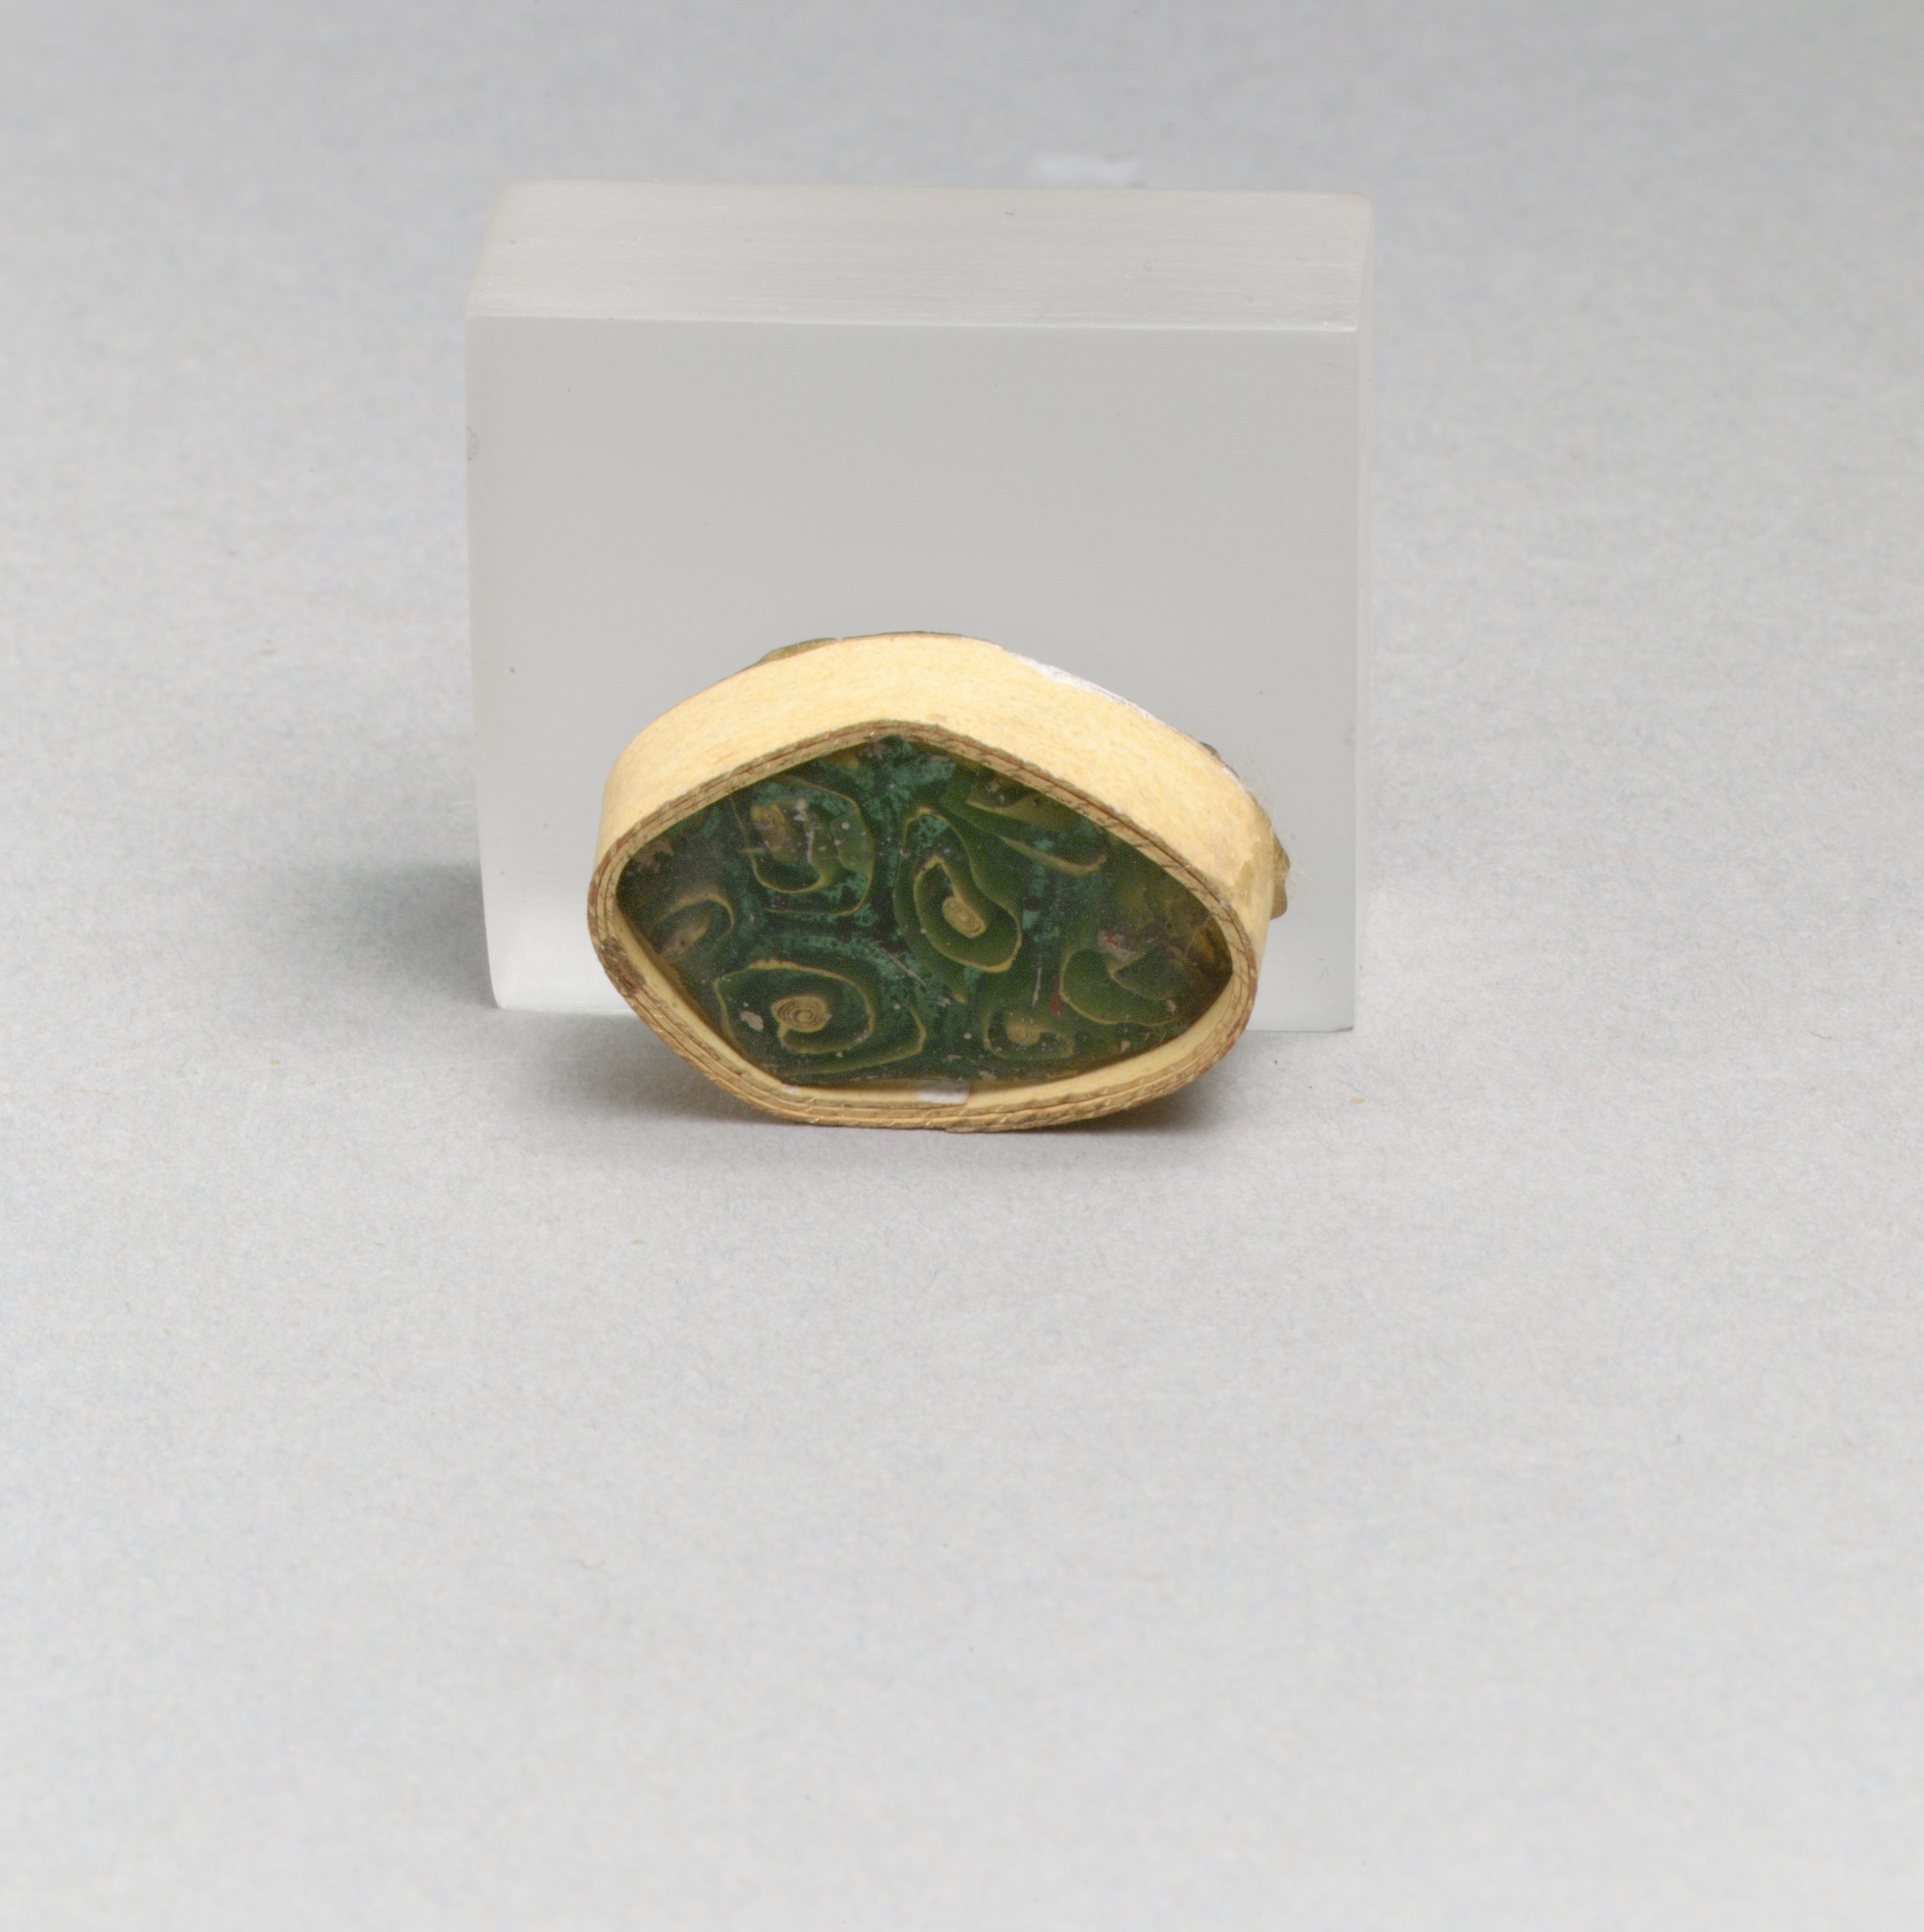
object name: fragment, mosaic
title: Glass mosaic fragment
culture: roman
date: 34 BCE-33 CE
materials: glass